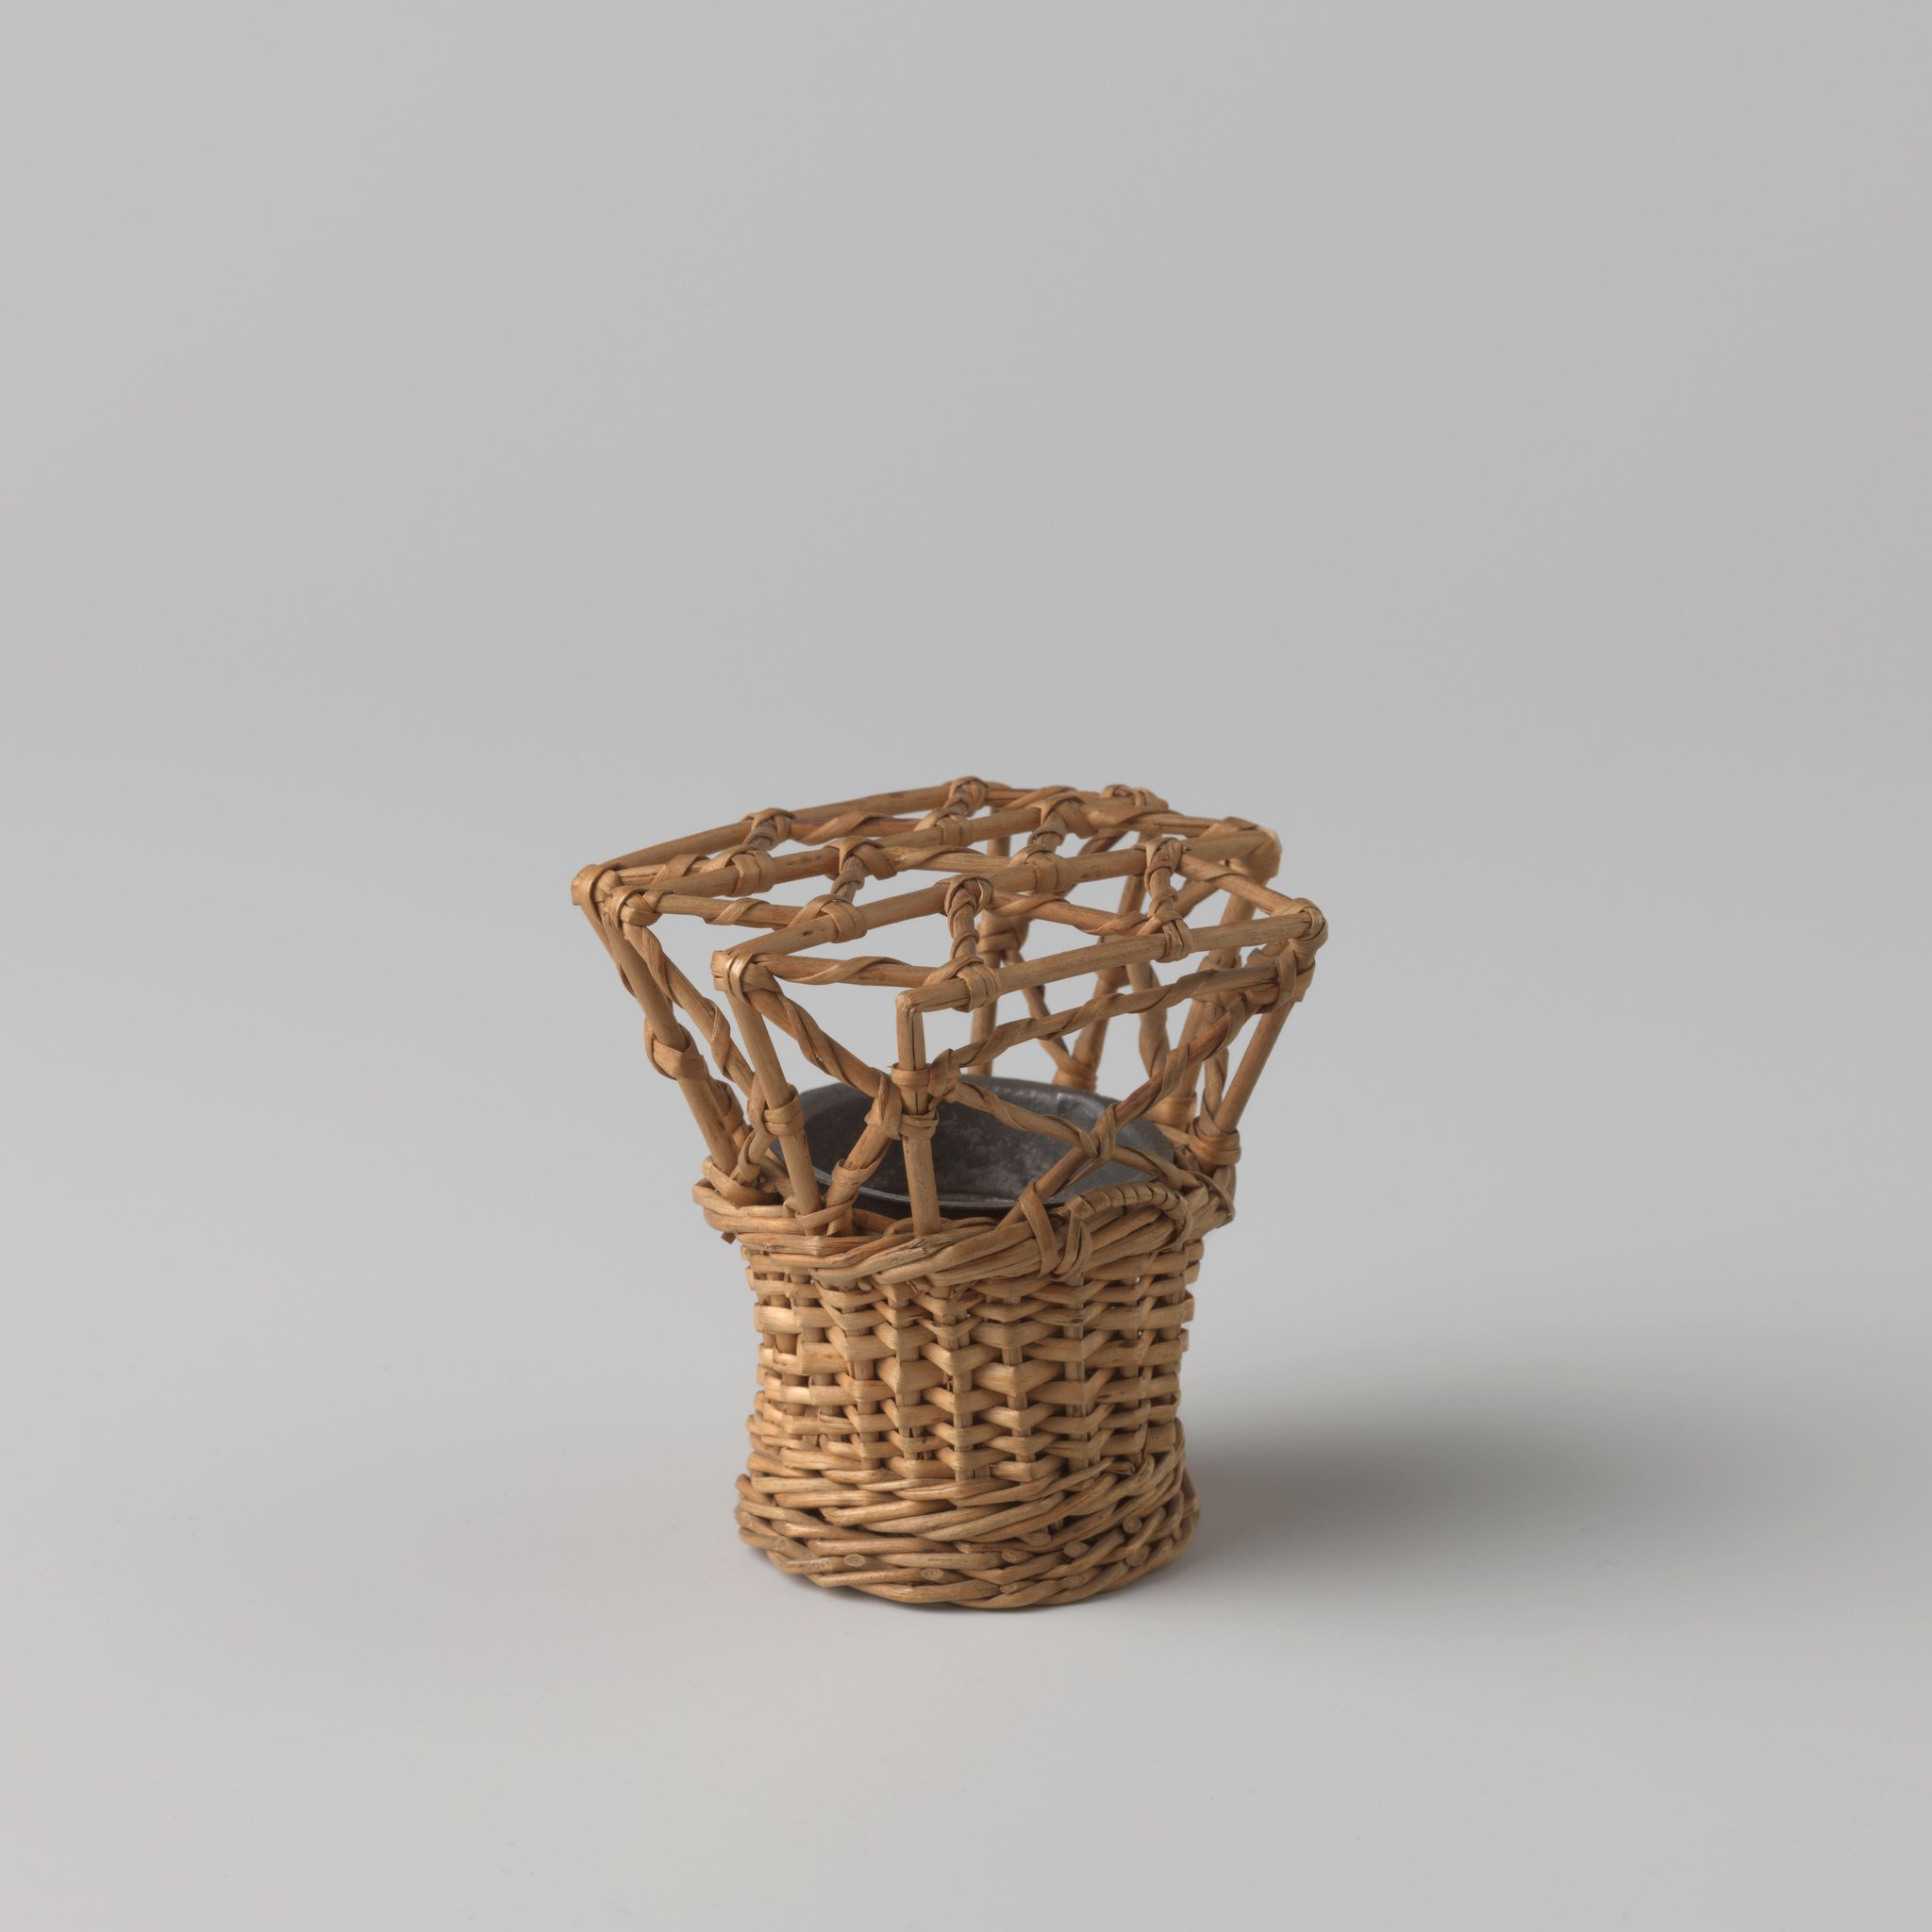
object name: miniature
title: Vuurmand, rond, met rechthoekige kap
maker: Anonymous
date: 1750-1800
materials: plant material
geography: netherlands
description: De vuurmand heeft een hoge ronde vorm met rechthoekige open "kapconstructie", vervaardigd van ronde en geslepen wilgenteen.